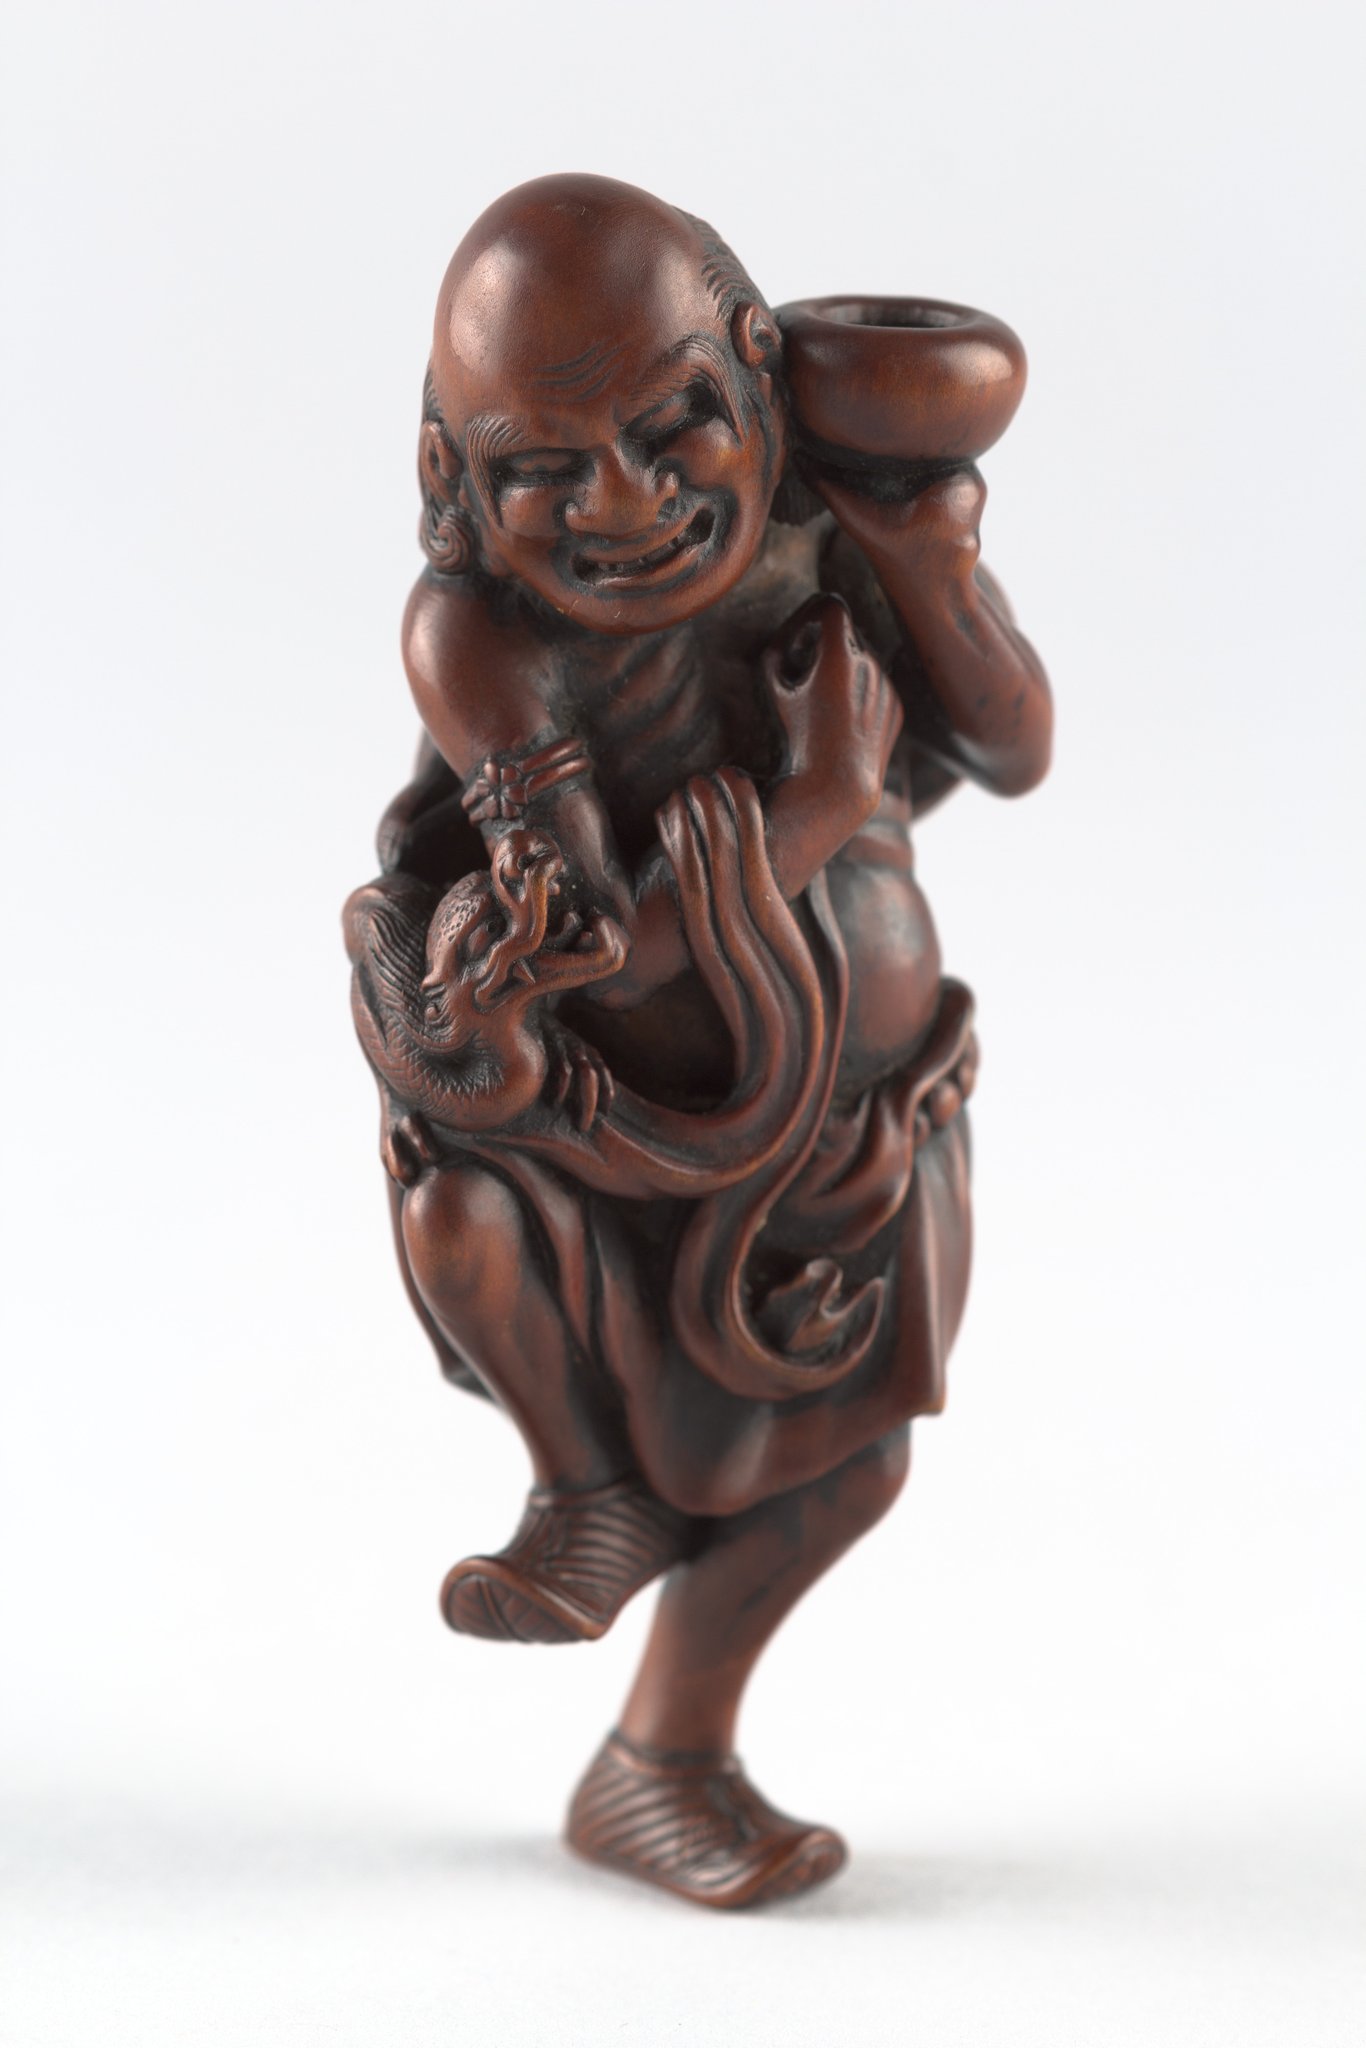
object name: netsuke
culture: japanese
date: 1801-1900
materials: wood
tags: men,fish